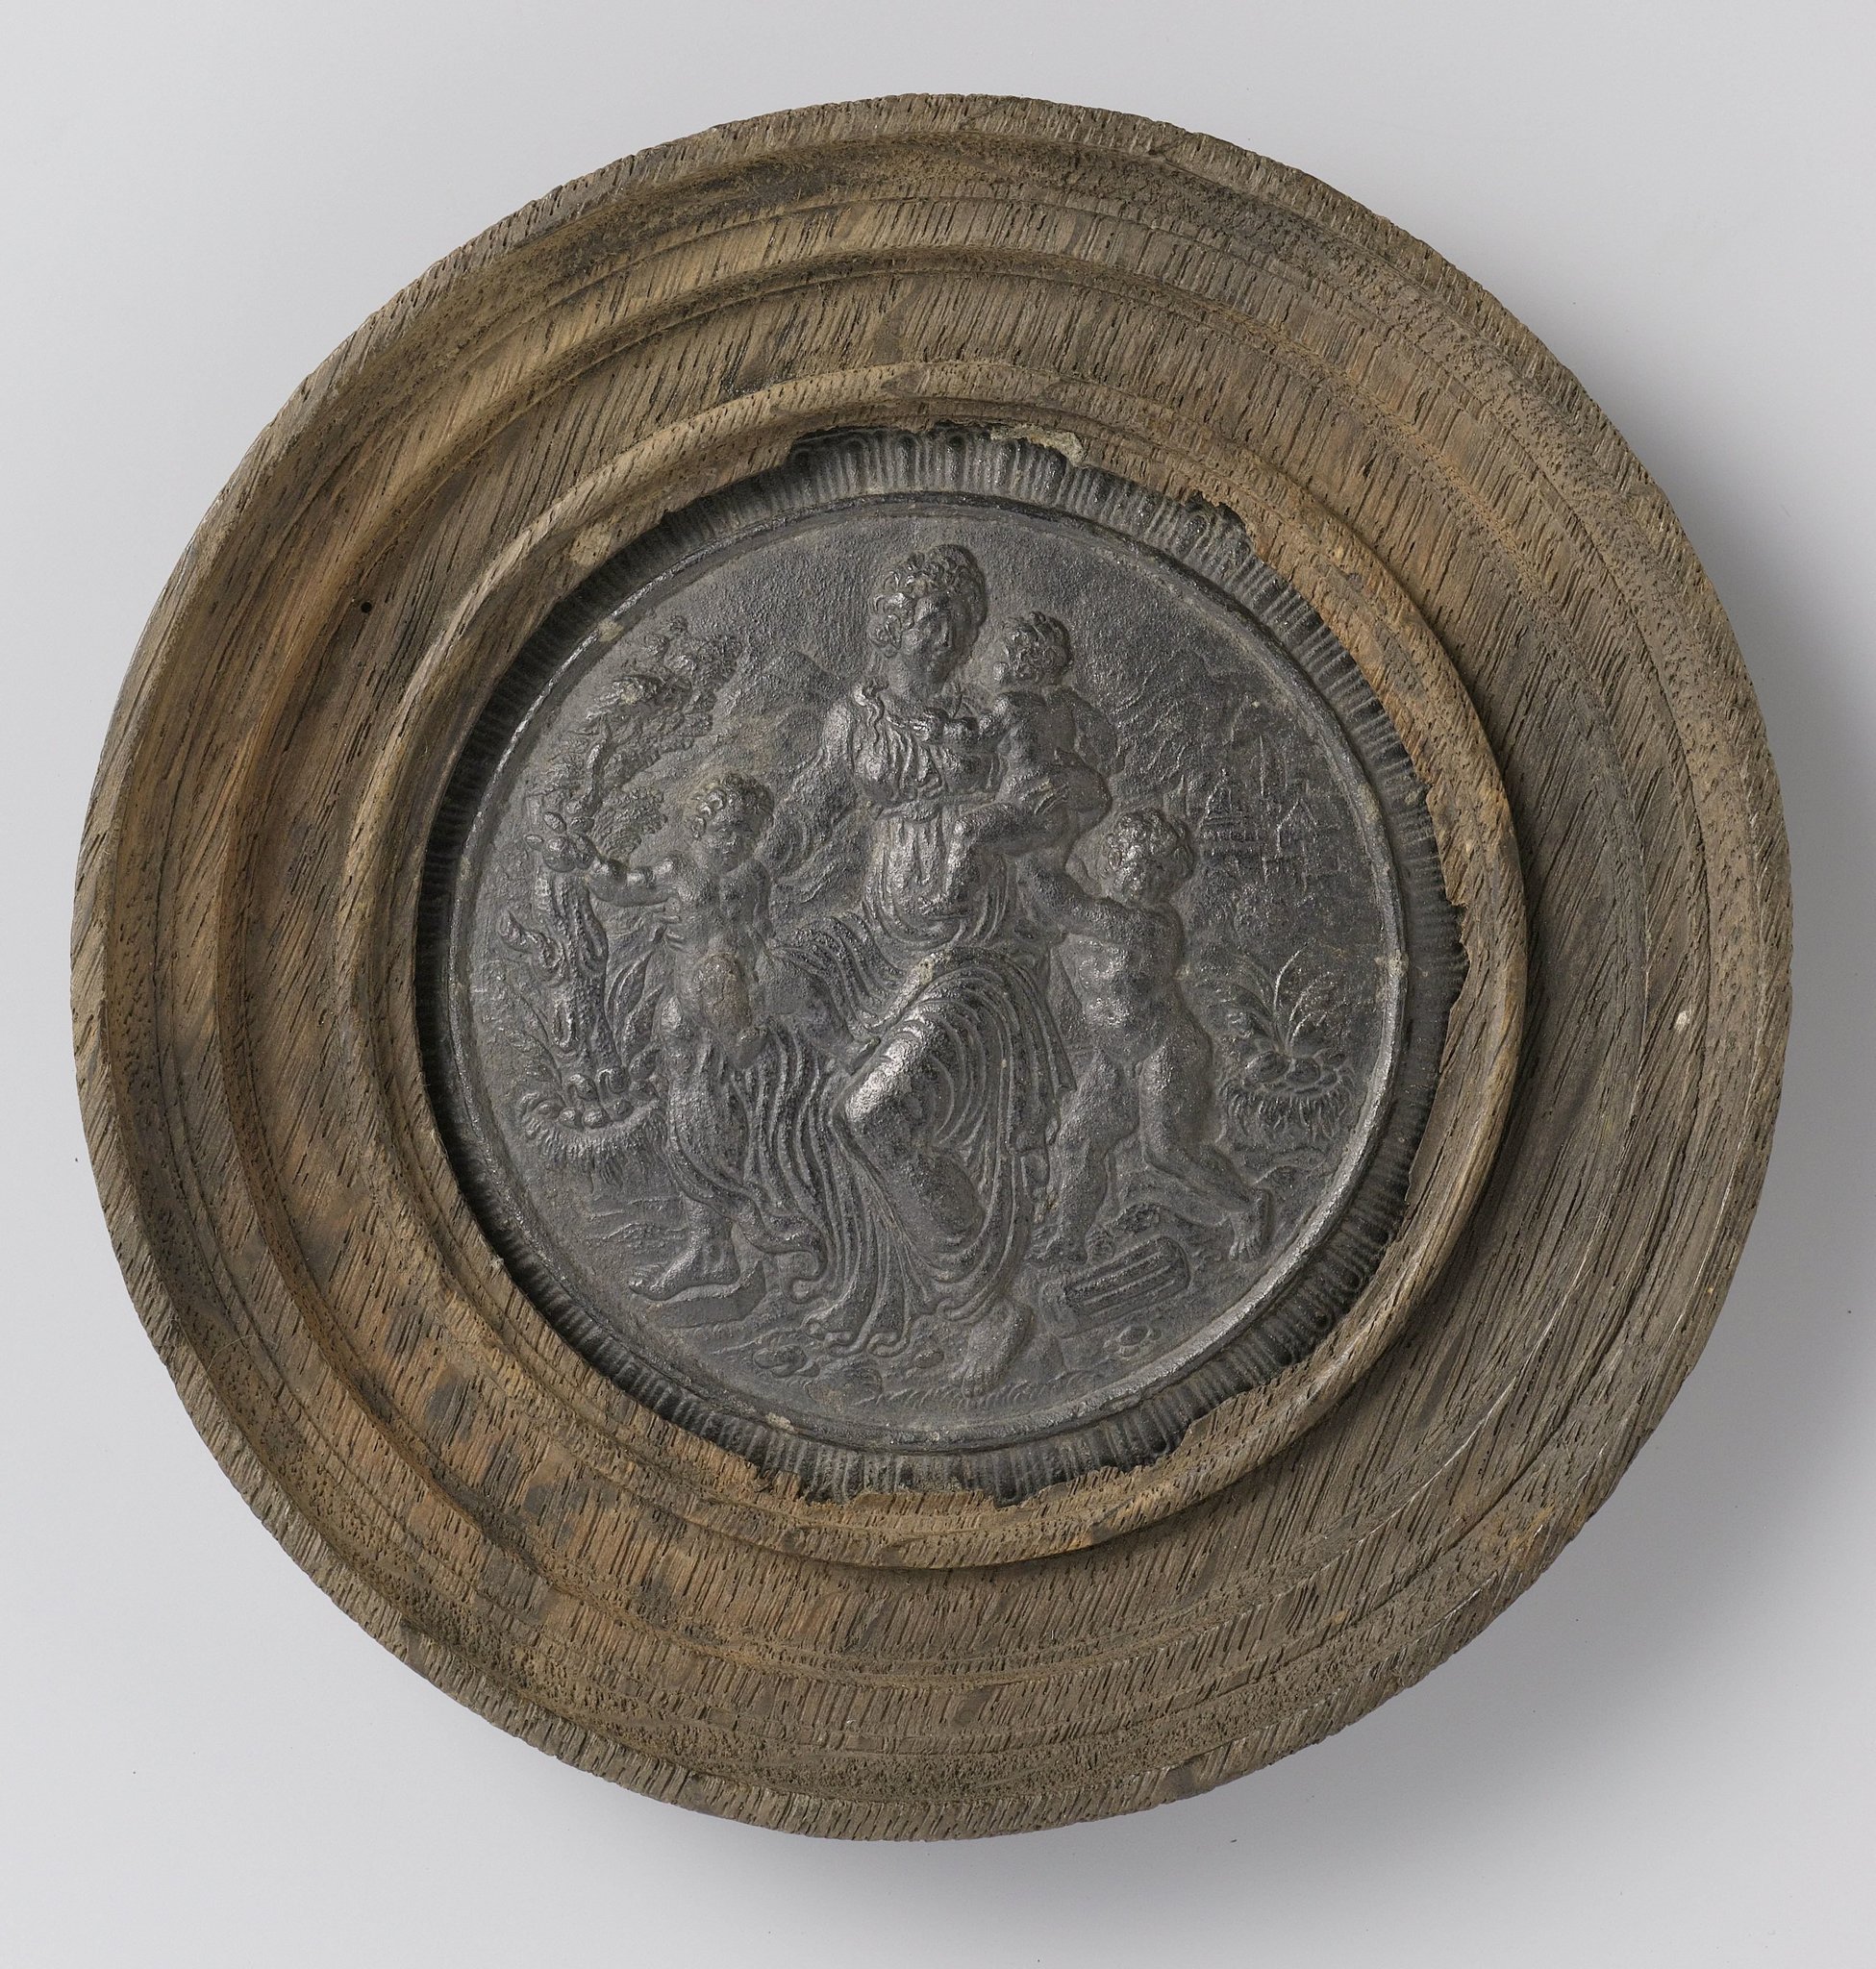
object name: locket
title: Merchandise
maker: Anonymous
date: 1590-1596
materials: tin, wood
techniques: casting, cutting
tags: willem barendsz., amsterdam, jacob van heemskerck, charity, 'caritas'; 'carità' (ripa) ~ one of the three theological virtues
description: Among the merchandise intended for the Asian market were pewter salt-cellars and a splendidly ornamented ewer. The pewter medallions in wooden frames were meant to serve as wall decorations.